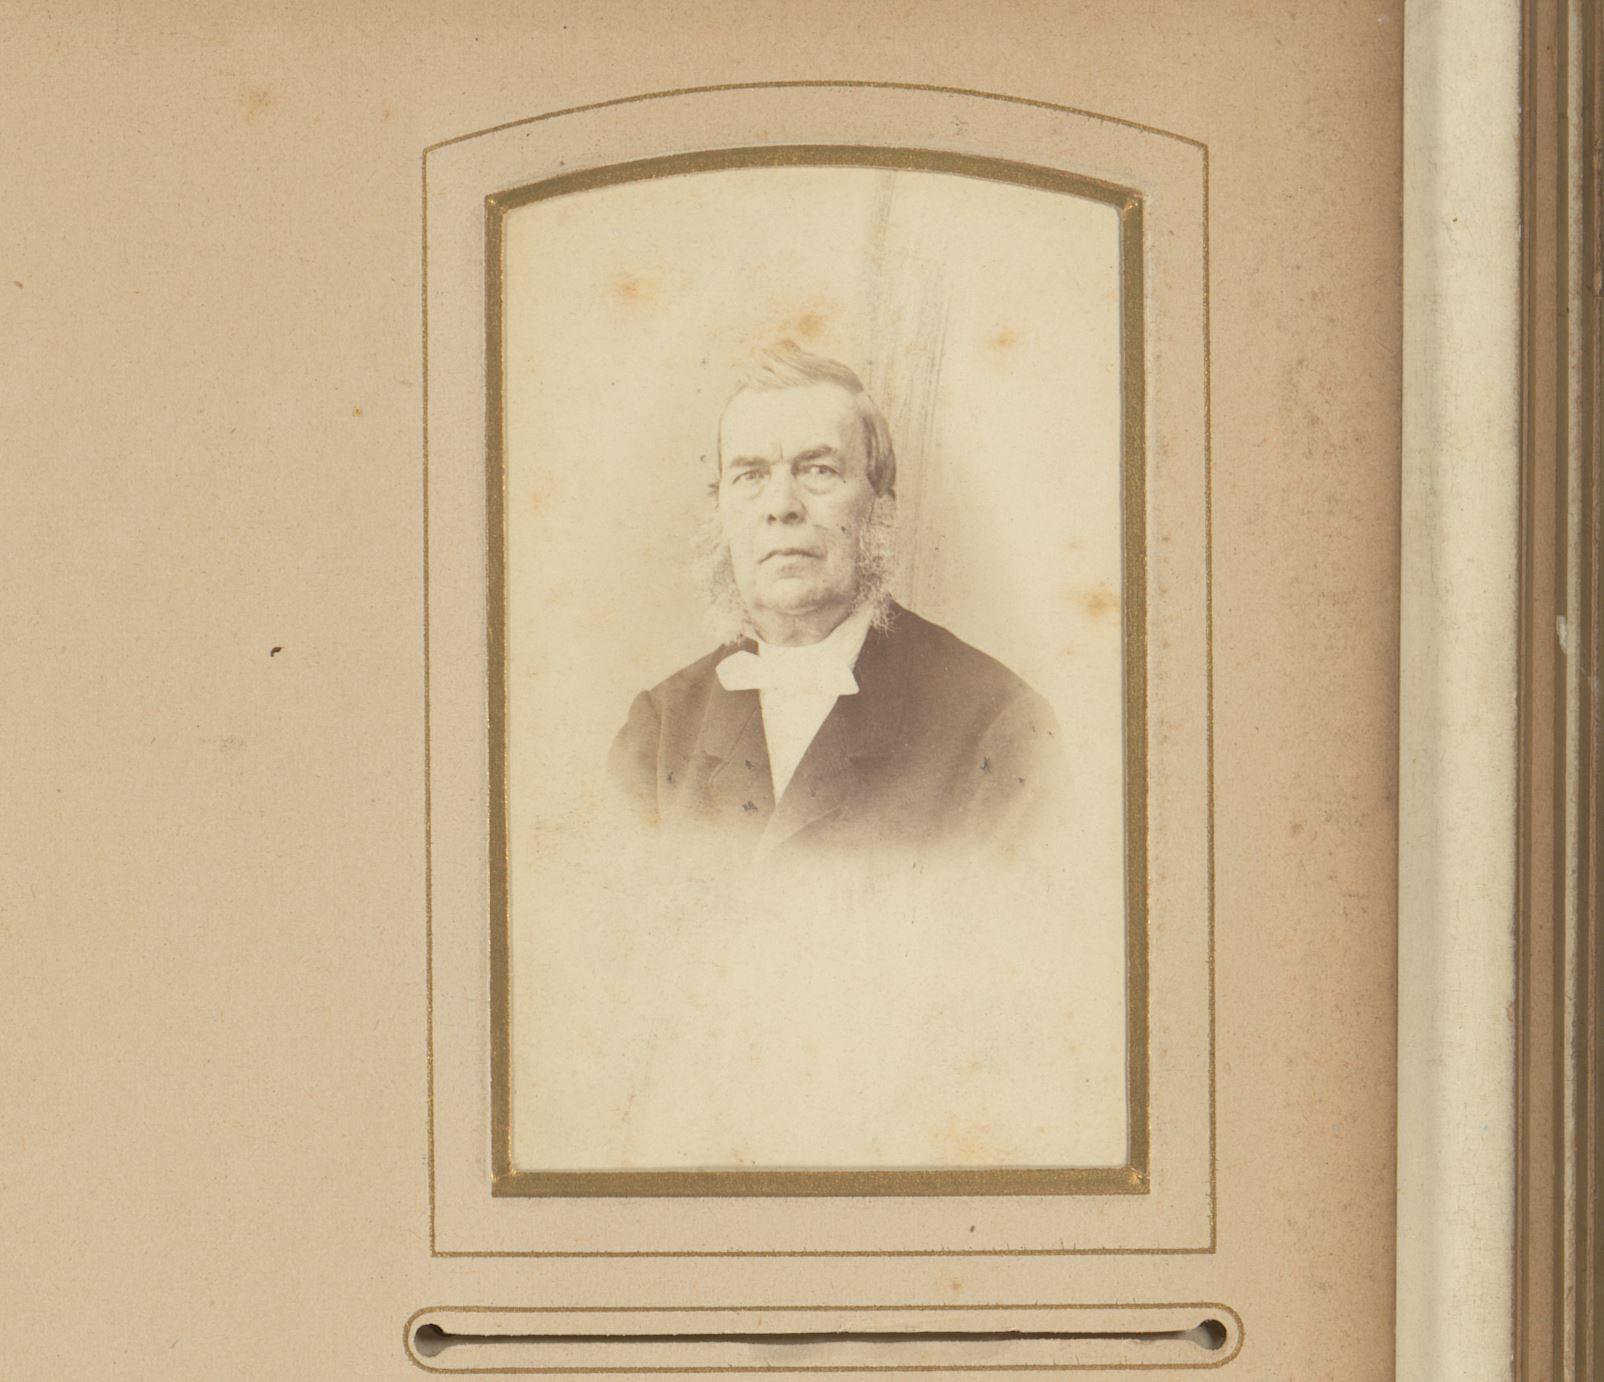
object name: carte de visite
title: Portret van een man met bakkebaarden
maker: théophile brackelaire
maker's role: fotograaf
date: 1868-1887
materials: cardboard, photographic support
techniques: albumen print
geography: doornik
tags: sideburns, historical persons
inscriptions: inscription: ‘ÉTABLISSEMENT PHOTOGRAPHIQUE/ DE/ Théophile BRACKELAIRE/ Rue Roc St. Nicaise, 17,/ TOURNAI.’